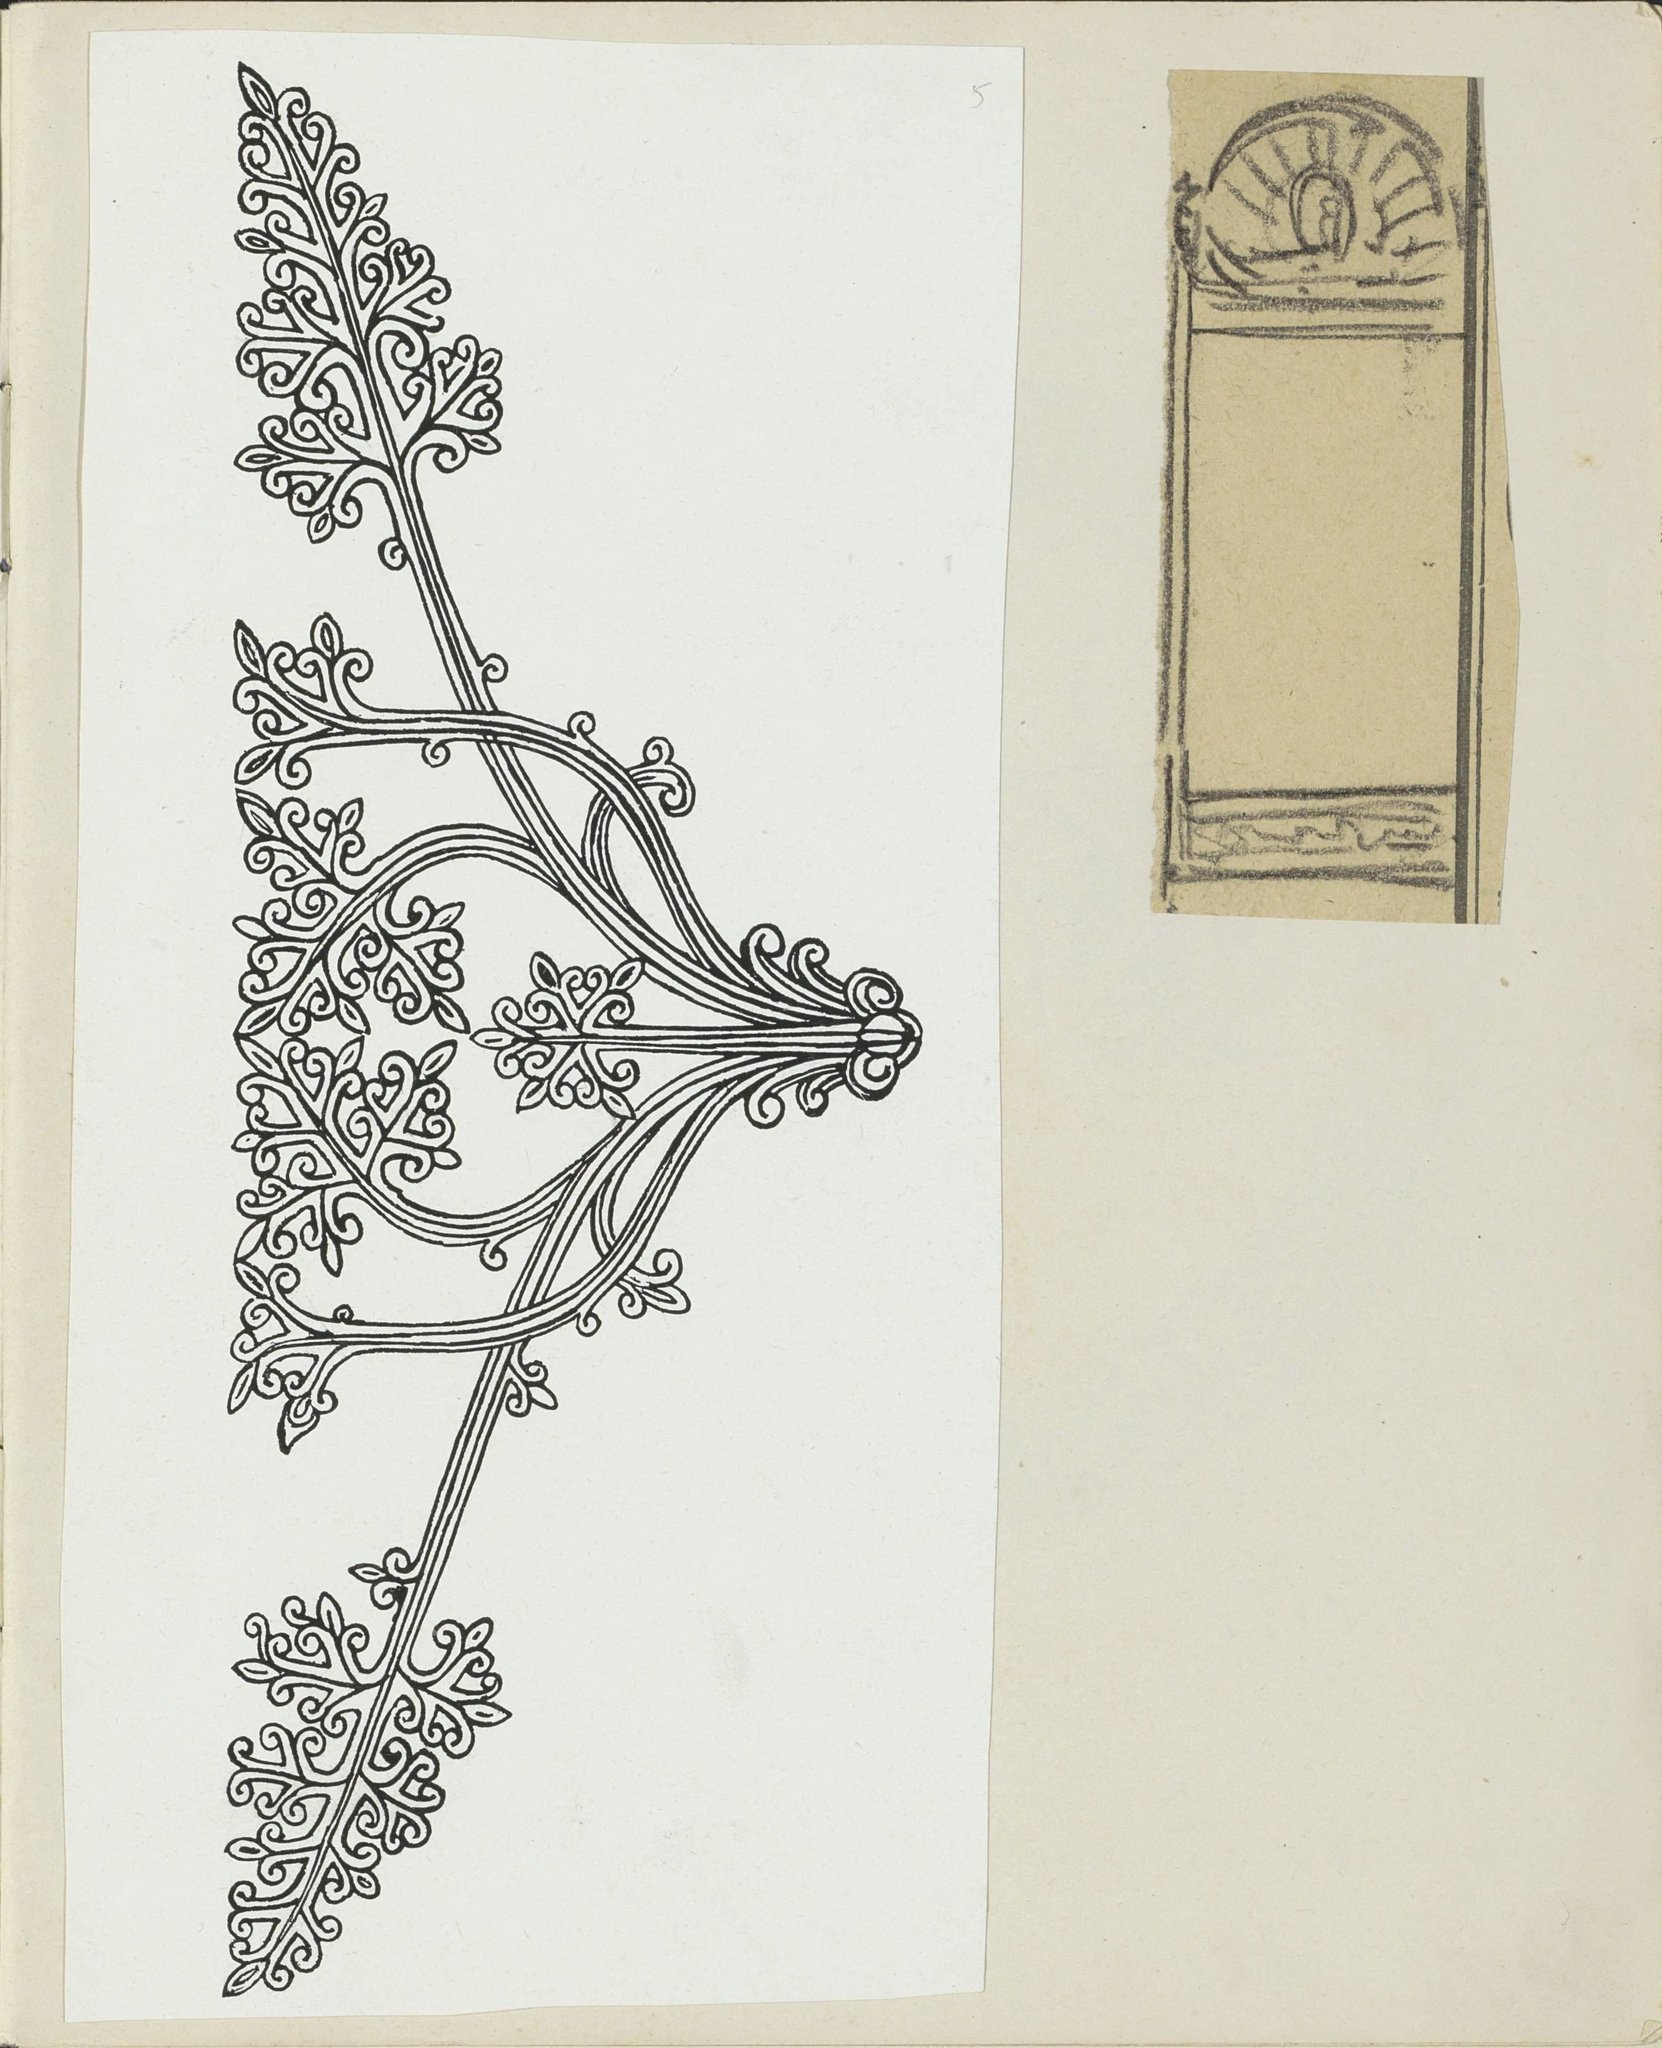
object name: album leaf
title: Ontwerp voor een venster en een ornament met bladeren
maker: gerrit willem dijsselhof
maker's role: designer, draughtsman, print maker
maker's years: 1866-1924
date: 1876-1924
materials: chalk, ink, paper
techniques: pen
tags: window, foliage, tendrils, branches ~ ornament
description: Blad 5 recto uit een album met 17 bladen.